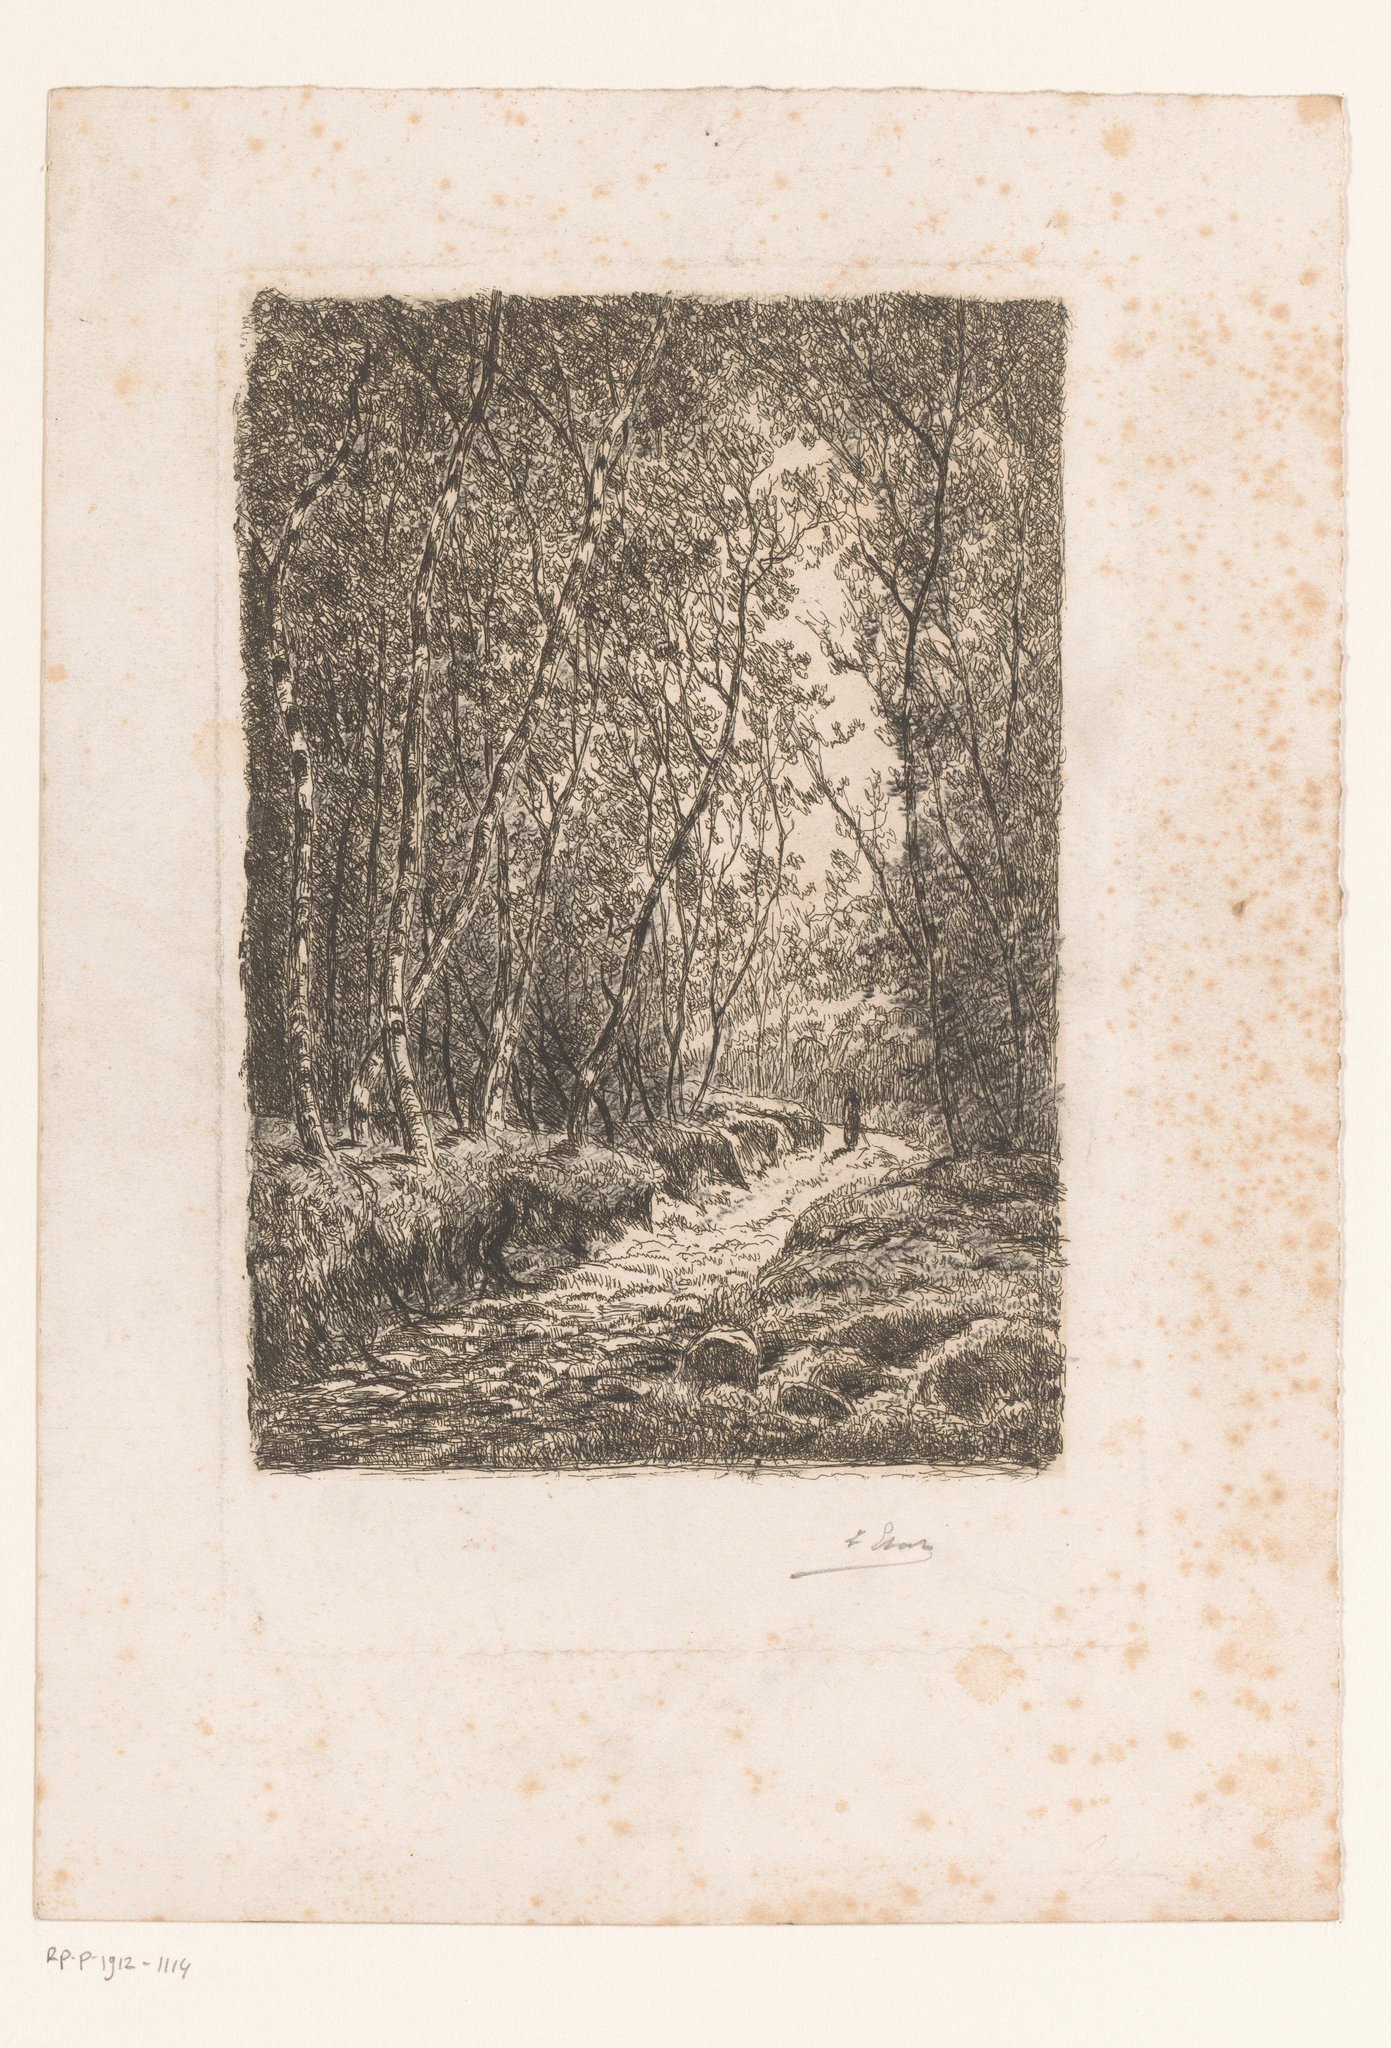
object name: print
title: Figuur op een bospad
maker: jozef van luppen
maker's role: print maker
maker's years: 1834-1891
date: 1844-1891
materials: chalk, paper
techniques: etching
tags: forest, wood, forest path or lane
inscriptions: inscription: ‘[4] etat’, collector's mark: Lugt 2228